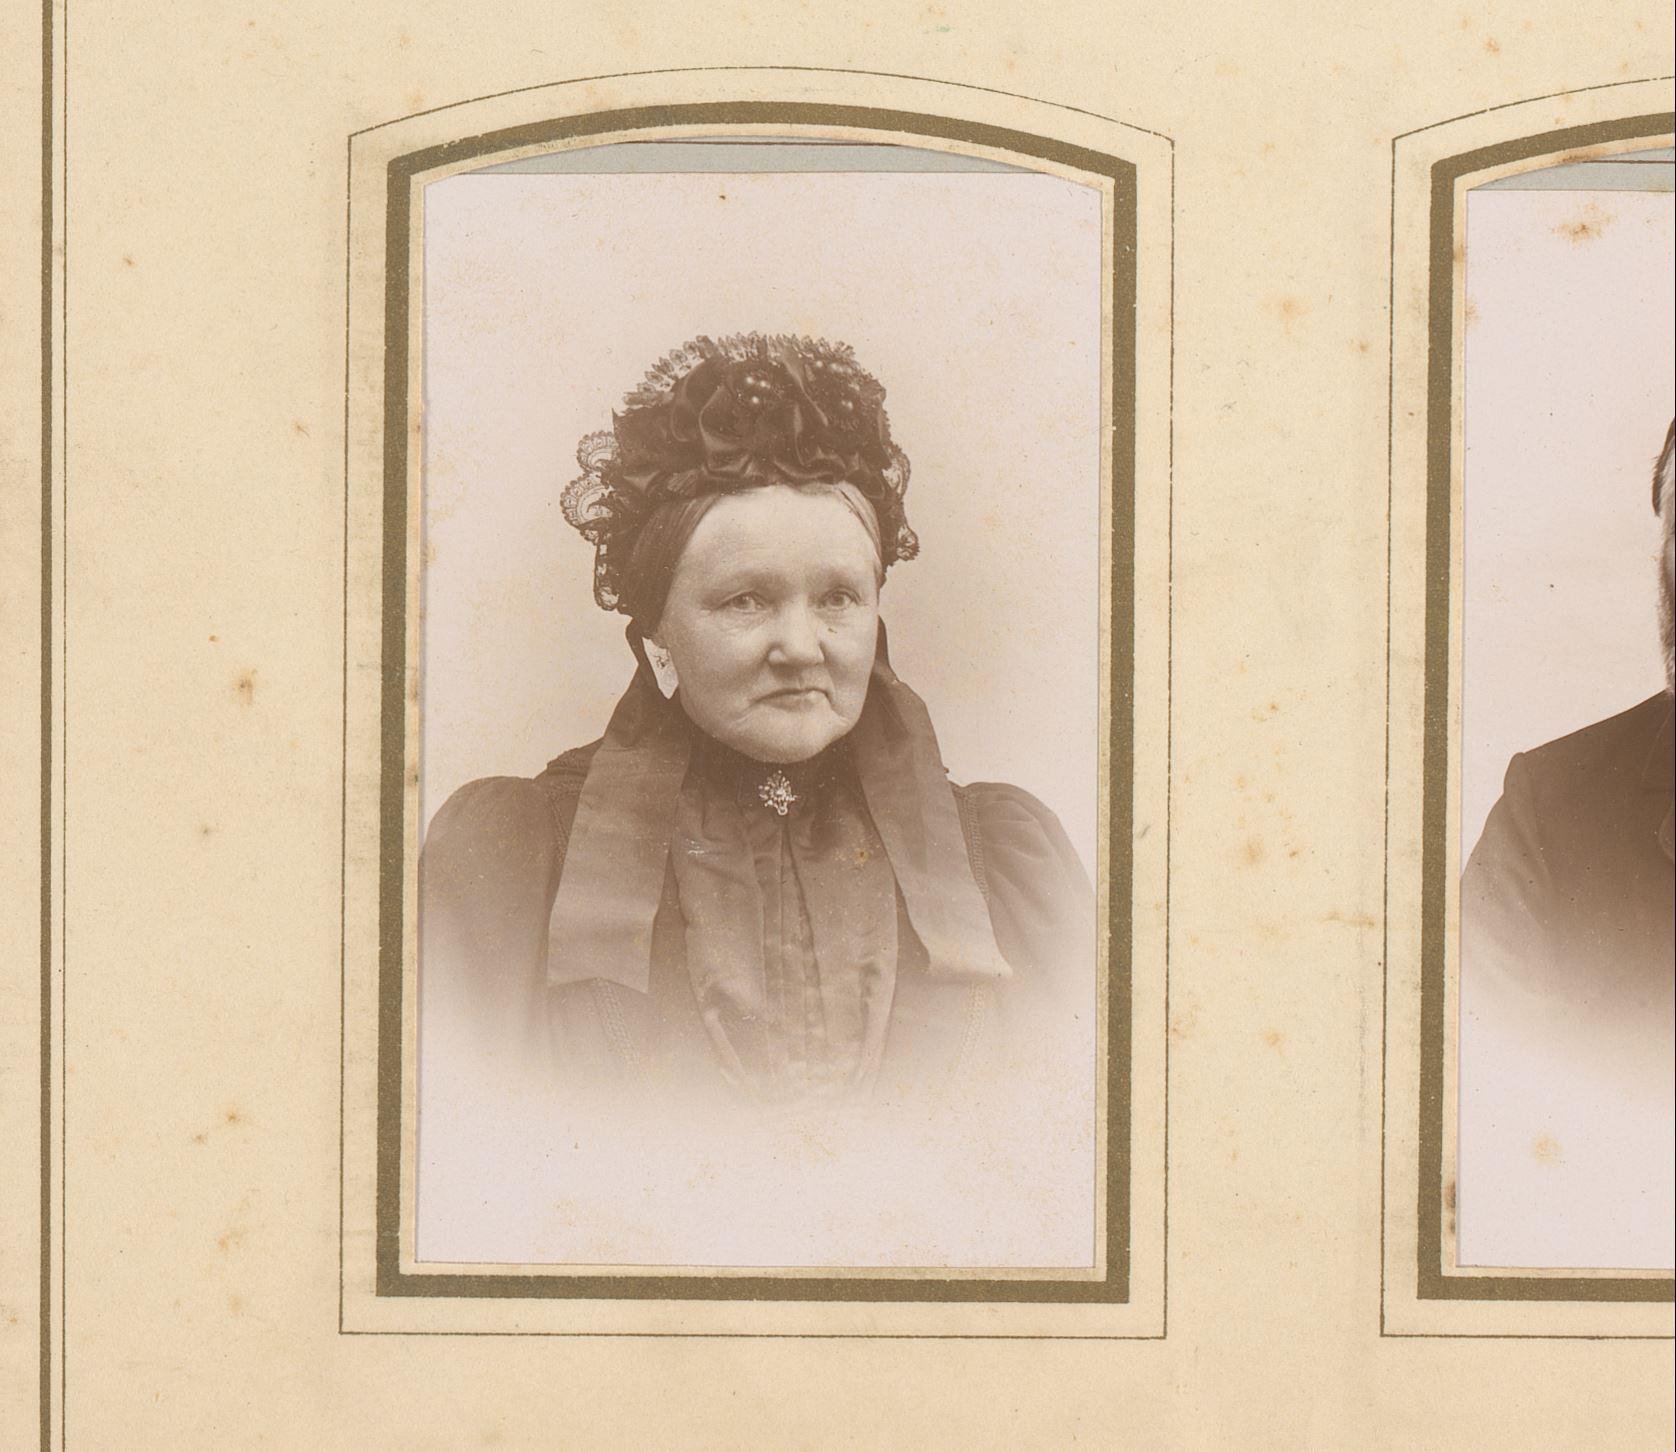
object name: photograph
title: Portret van een vrouw met muts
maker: pieter duiker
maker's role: fotograaf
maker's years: 1853-1936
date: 1878-1936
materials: cardboard, photographic support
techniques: collodion silver print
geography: hoogezand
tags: historical persons - bb - woman, head-gear: cap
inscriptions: inscription: ‘Photographie/ Artistique/ P. Duiker/ photograaf/ Hoogezand./ De plaat blijft ter nabestelling bewaard.’